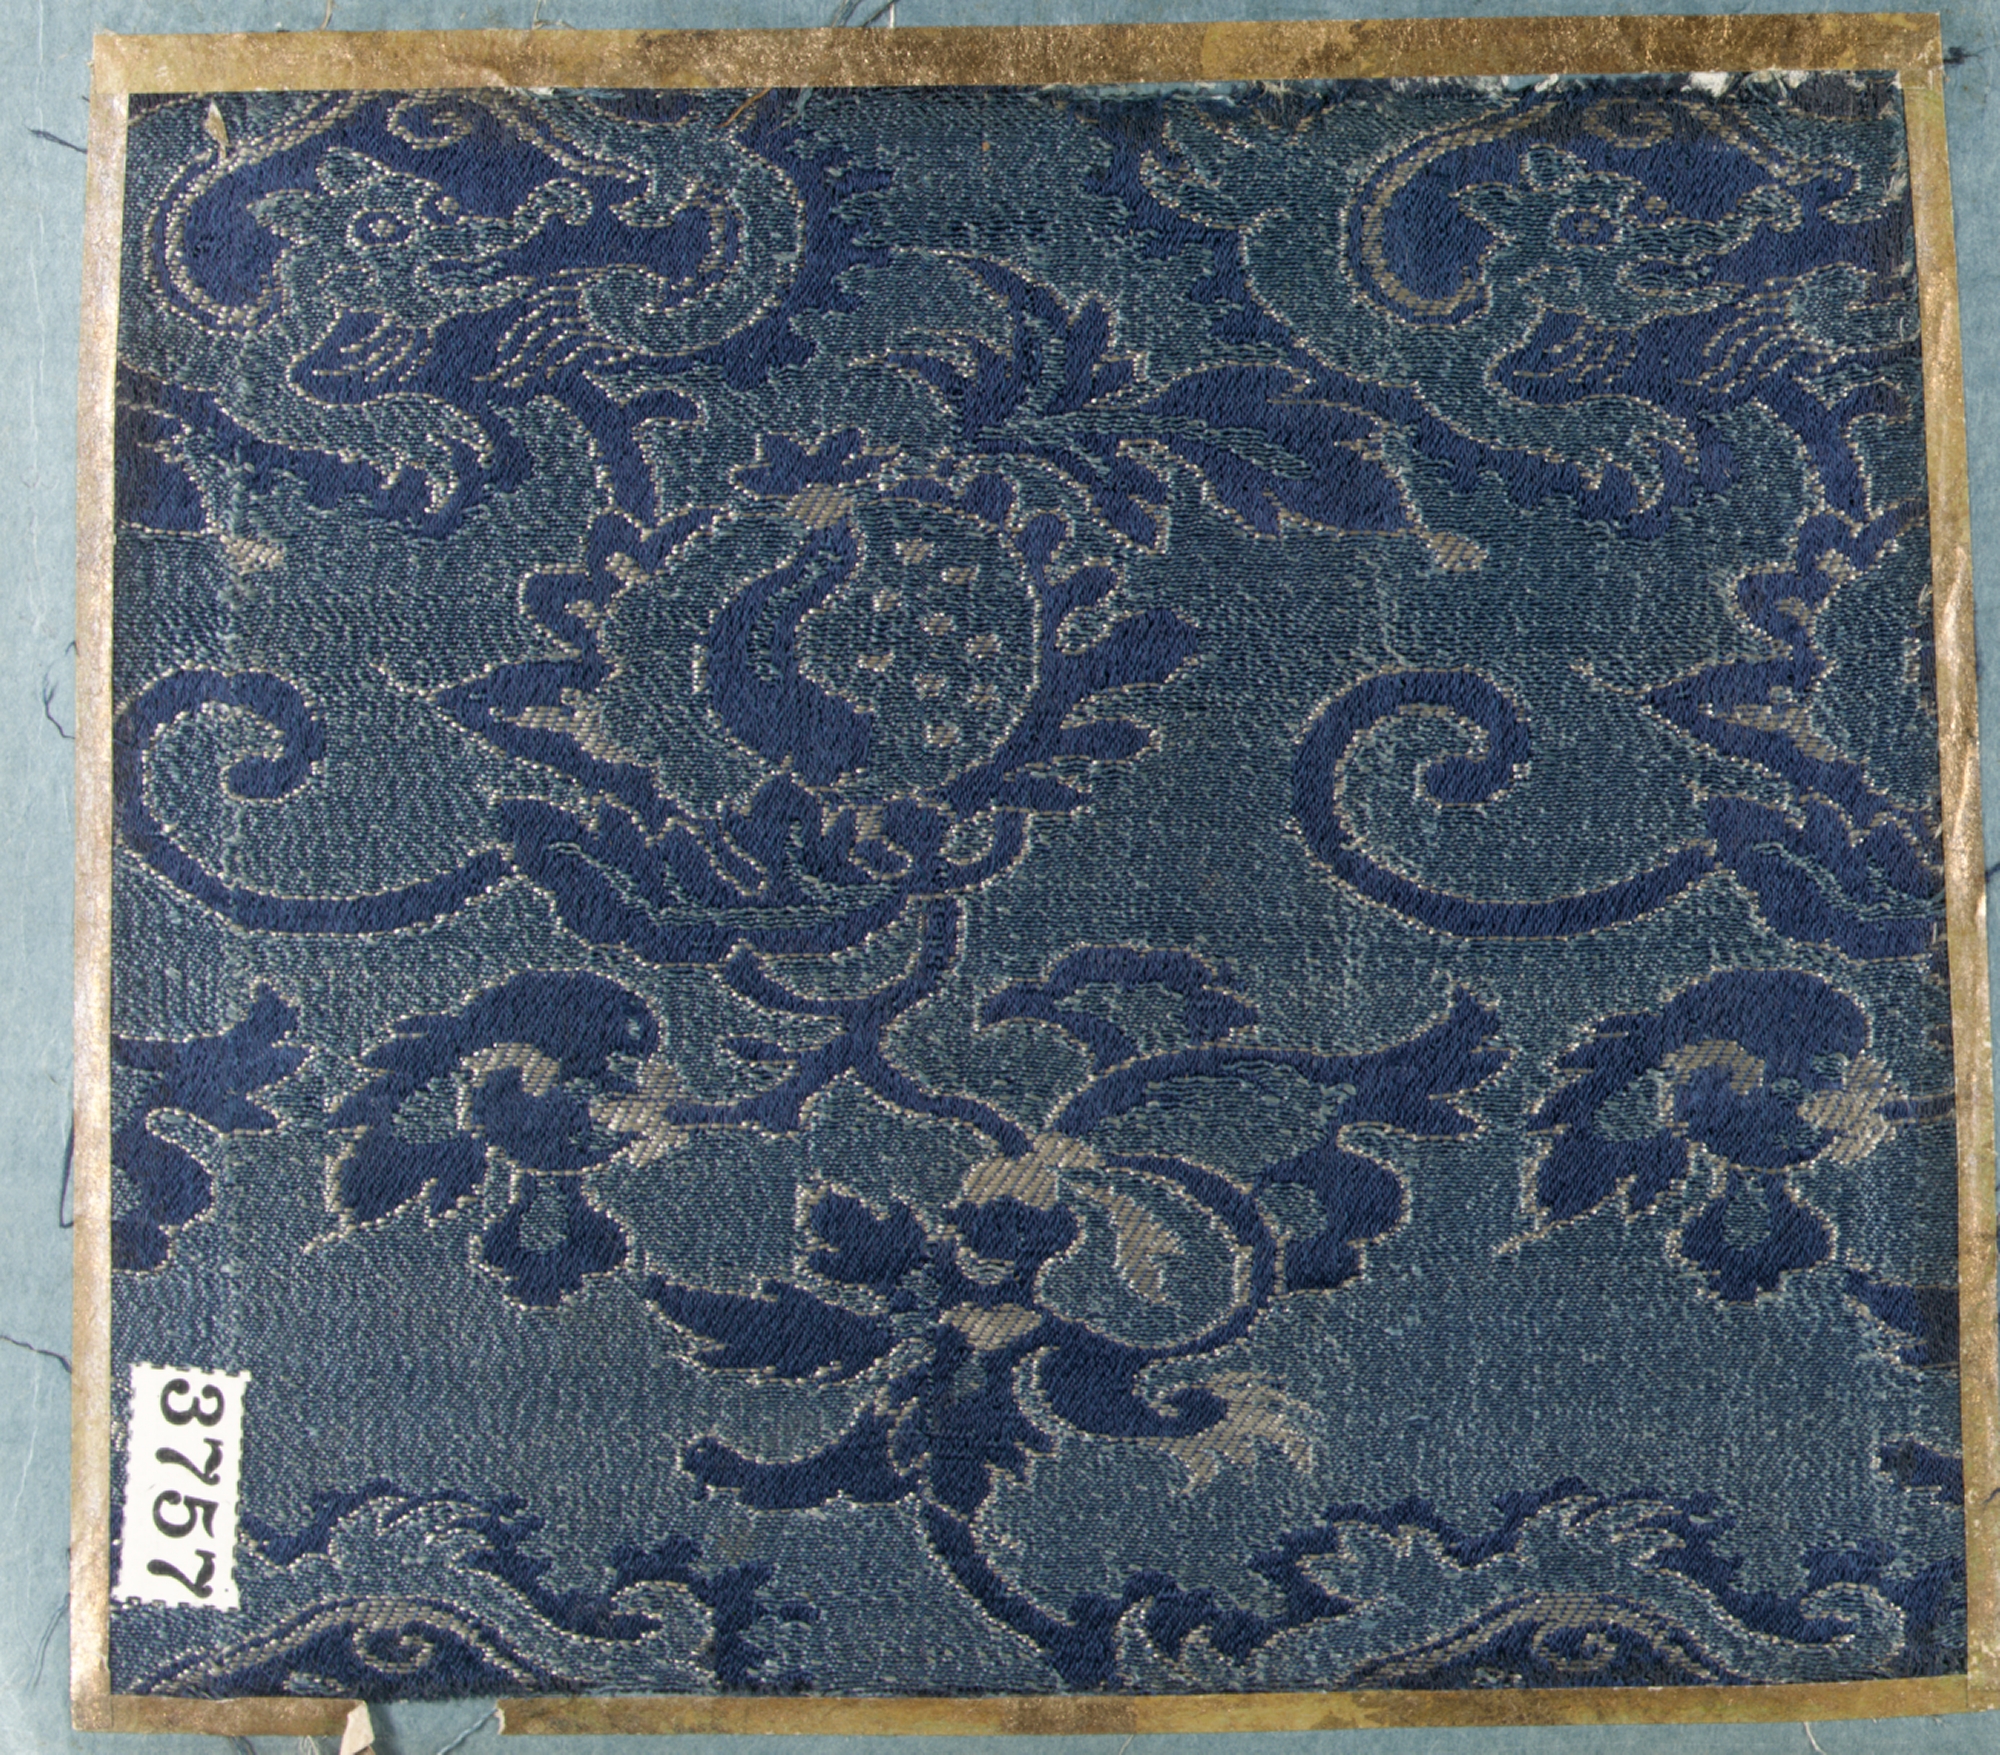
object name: sample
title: Textile Sample from Sample Book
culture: japanese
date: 1801-1900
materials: silk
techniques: tapestry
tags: flowers